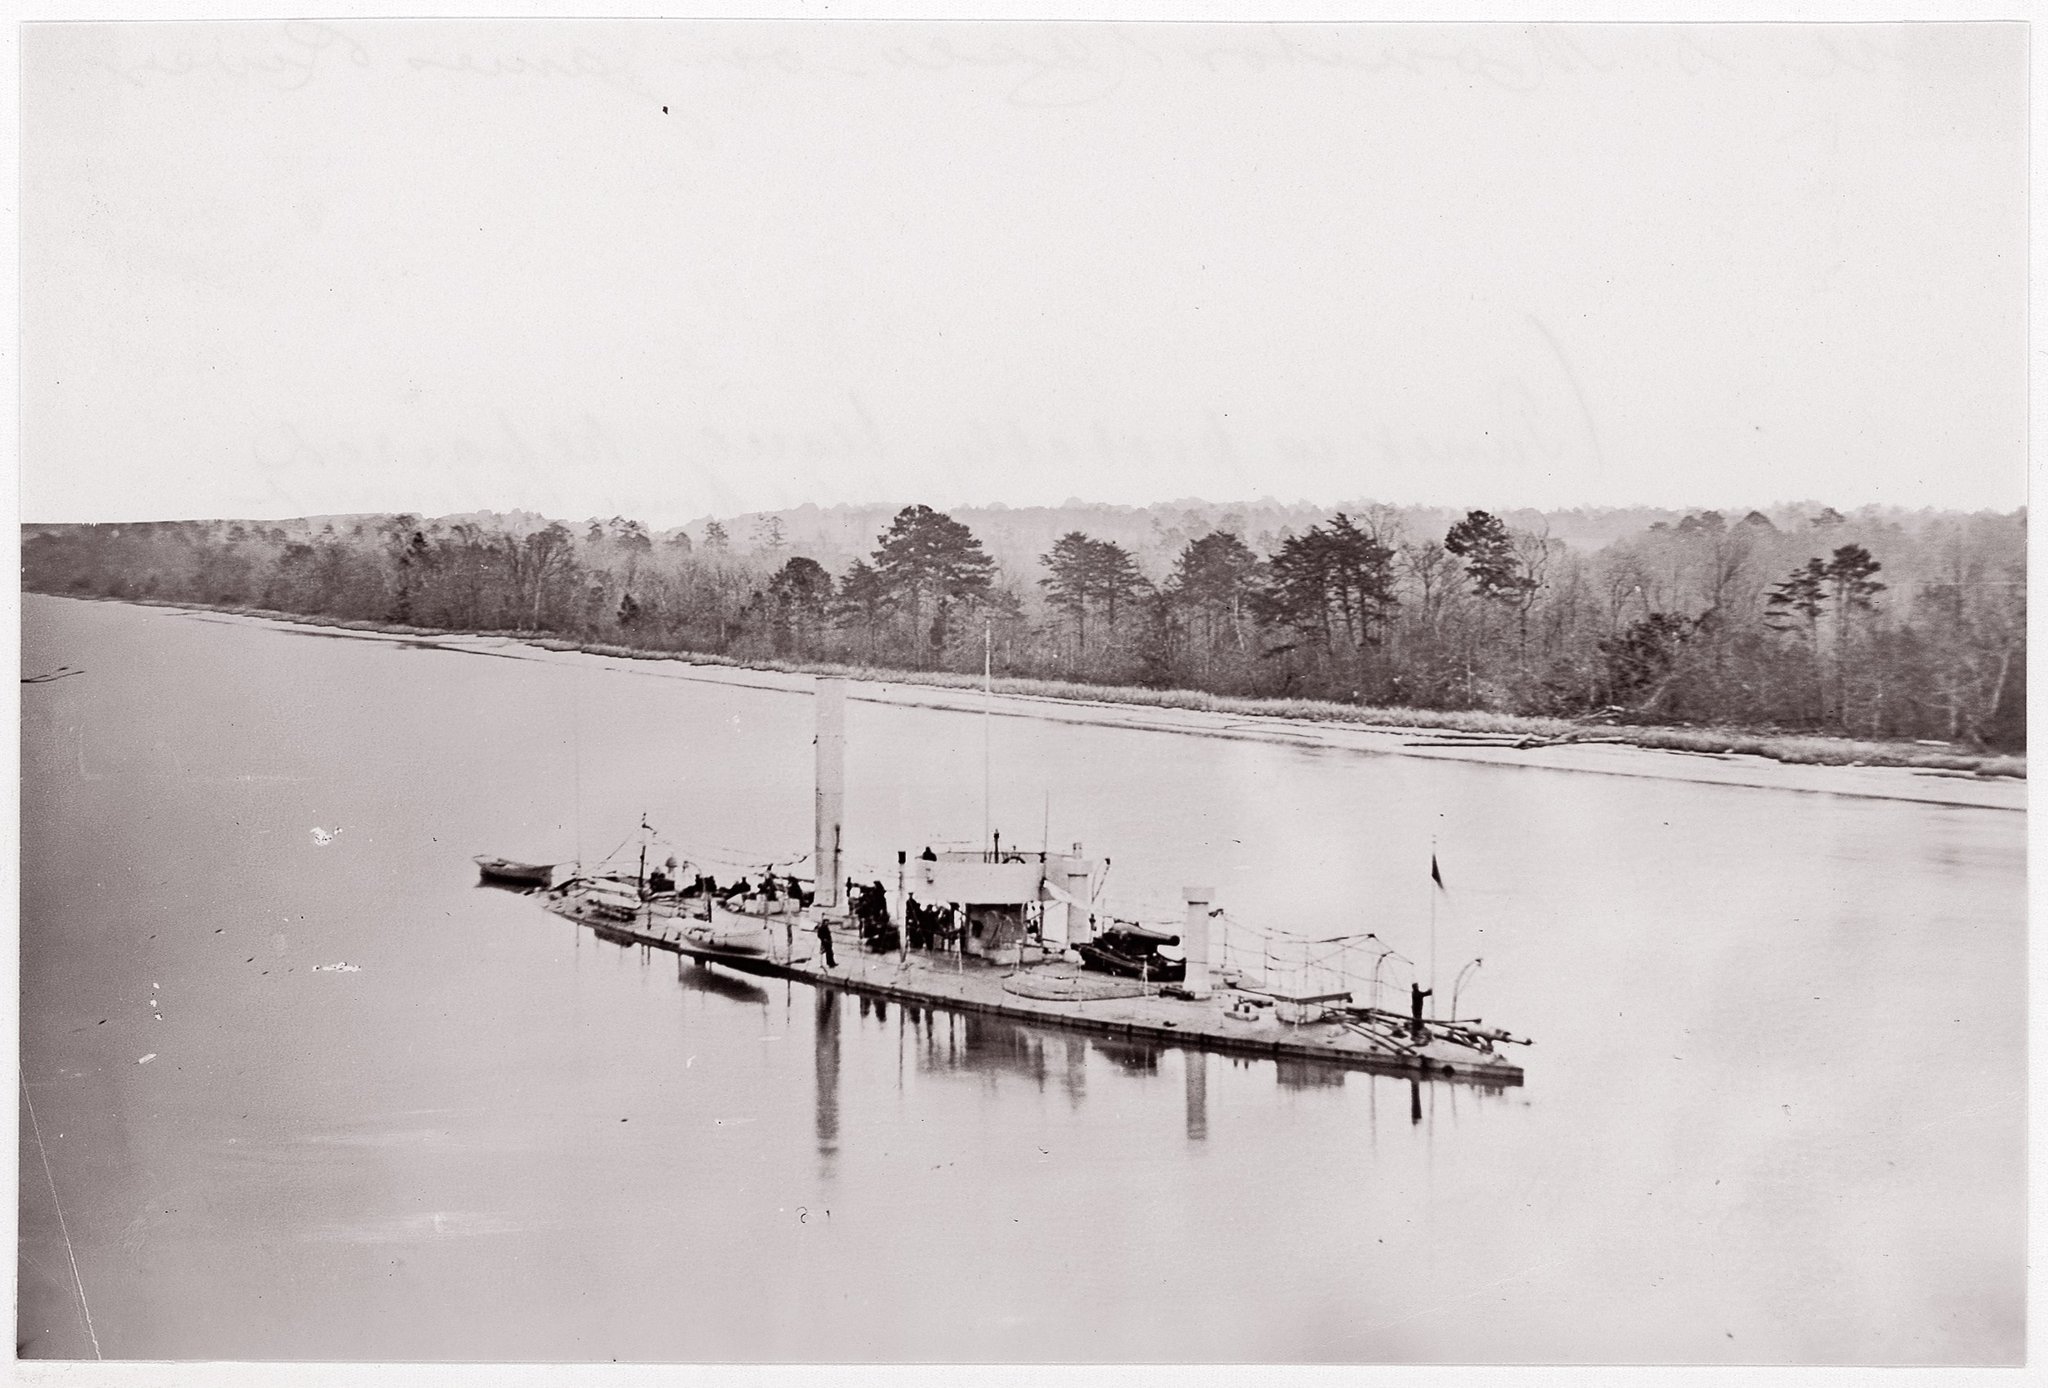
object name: photograph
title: U.S. Monitor "Casco" on James River, taken from a lookout tower on bank.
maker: Anonymous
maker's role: artist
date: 1861-1865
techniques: albumen silver print, glass negative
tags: cannons,american civil war,rivers,ships